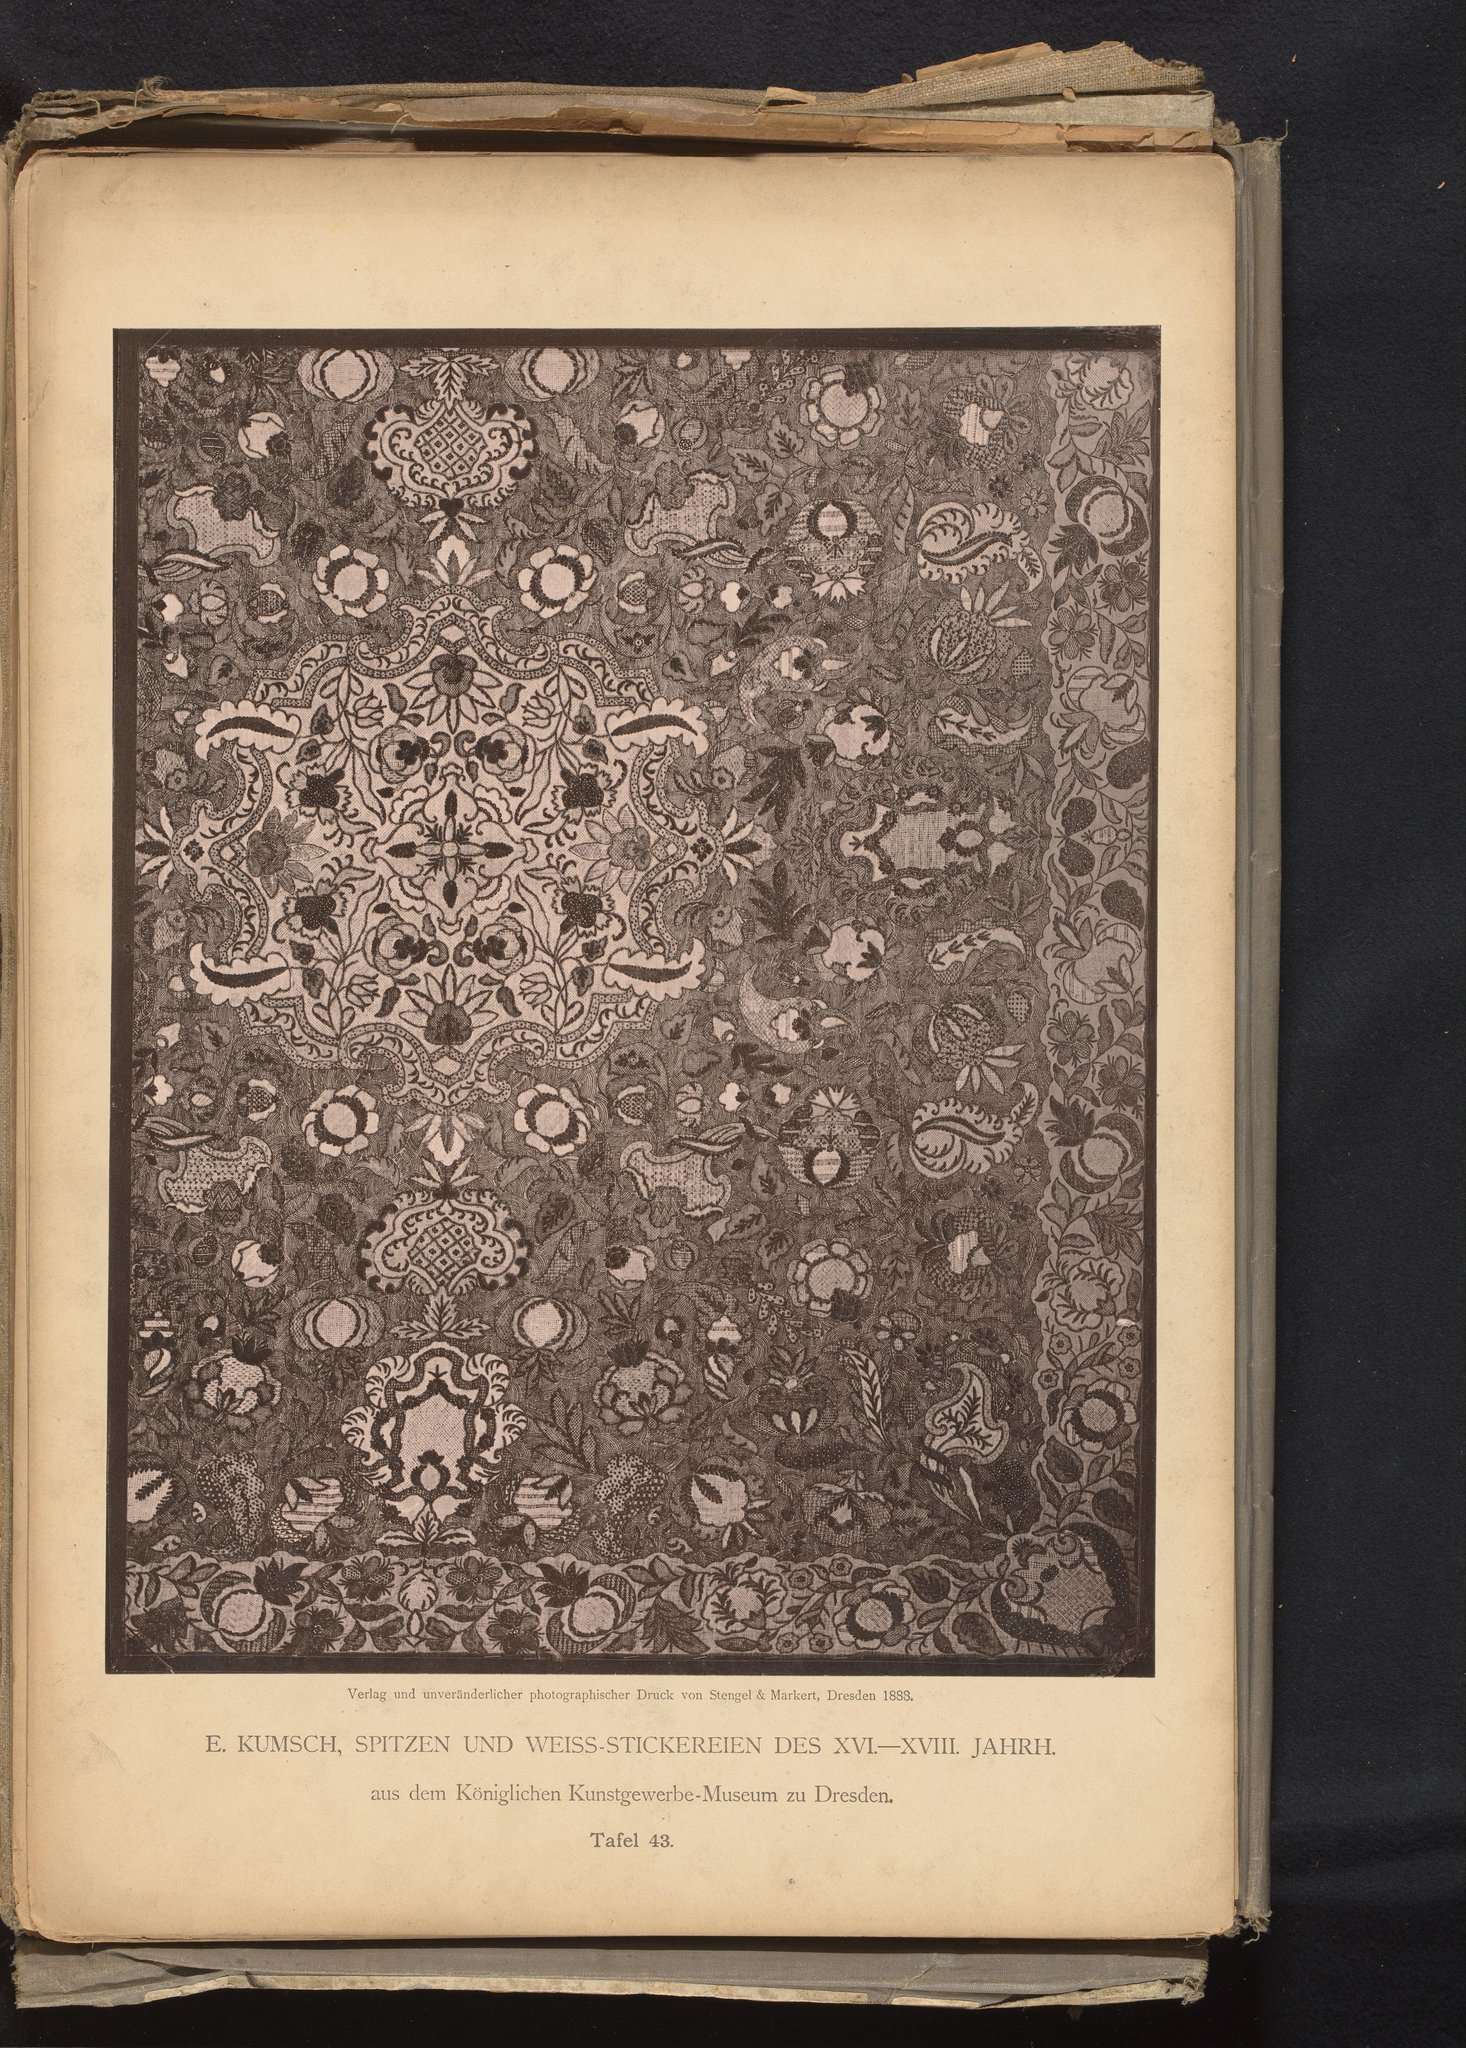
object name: photomechanical print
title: 18de-eeuws geborduurd Duits laken uit de collectie van het Kunstgewerbemuseum in Dresden, Duitsland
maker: Anonymous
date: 1888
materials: paper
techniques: photograph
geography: dresden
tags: bedding, embroidery (ornamentation)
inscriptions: number: ‘Tafel 43.’, inscription: ‘E. KUMSCH, SPITZEN UND WEISS-STICKEREIEN DES XVI.-XVIII. JAHRH./ aus dem Königlichen Kunstgewerbe-Museum zu Dresden’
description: Deze prent maakt deel uit van een omslag met 49 prenten en een lijst van afbeeldingen.